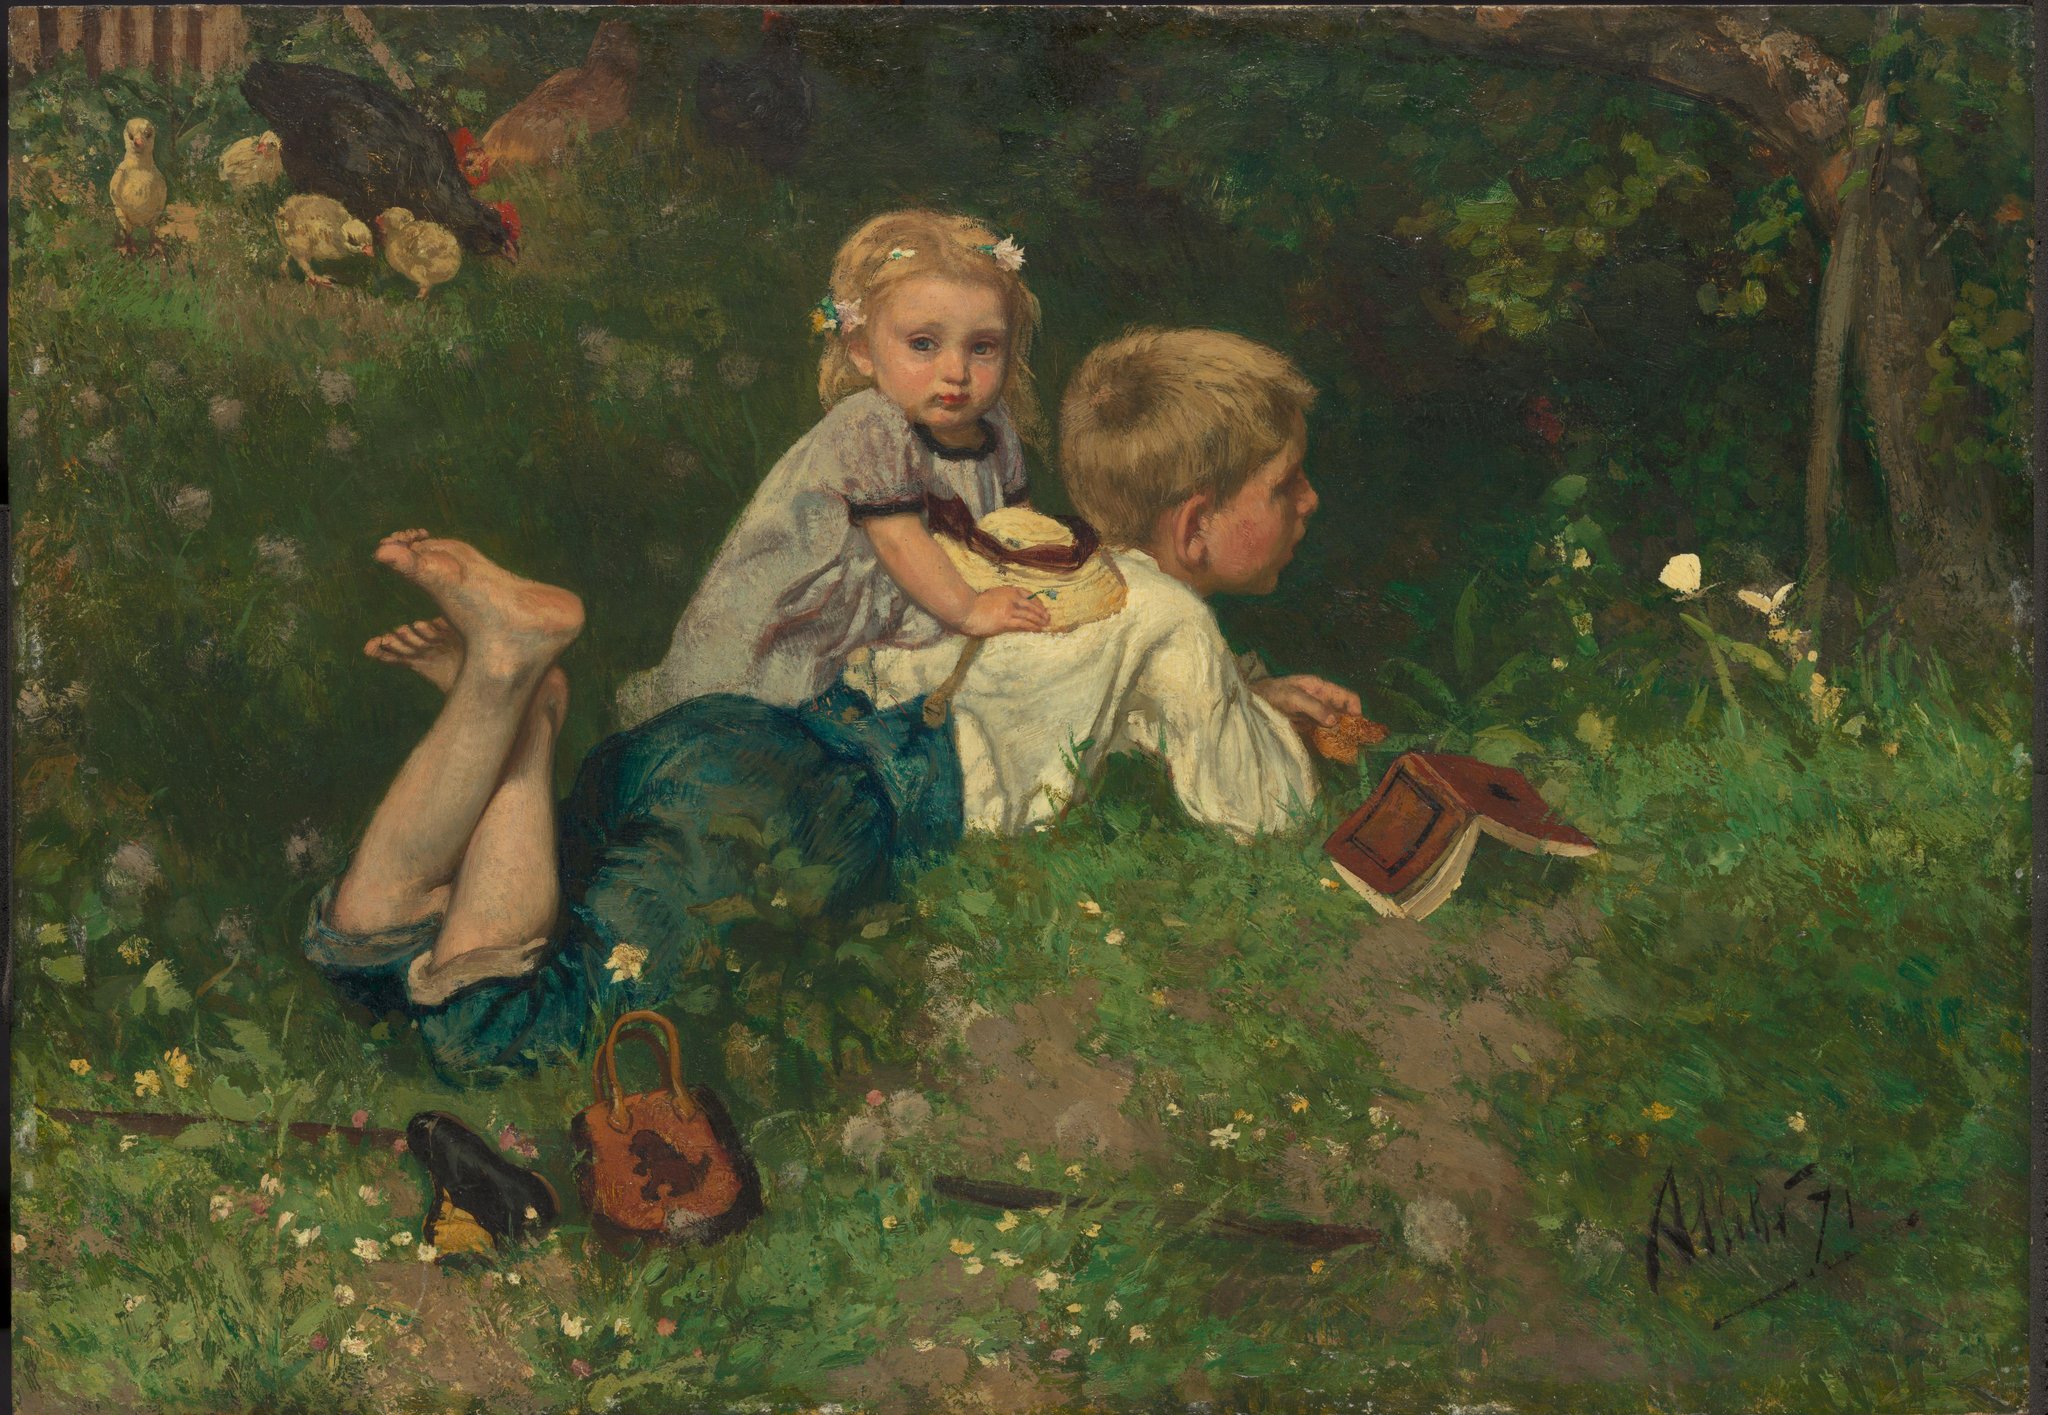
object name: painting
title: The Butterflies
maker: august allebé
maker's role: draughtsman, print maker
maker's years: 1838-1927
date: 1871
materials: oil, panel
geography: netherlands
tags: child, insects: butterfly, child and nature (games and plays)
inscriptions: signature and date: ‘Allebé 71’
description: Voorstelling getiteld 'De Vlinders'. Twee kinderen liggen in het gras en kijken naar vlinders. Linksachter een kip met kuikens.